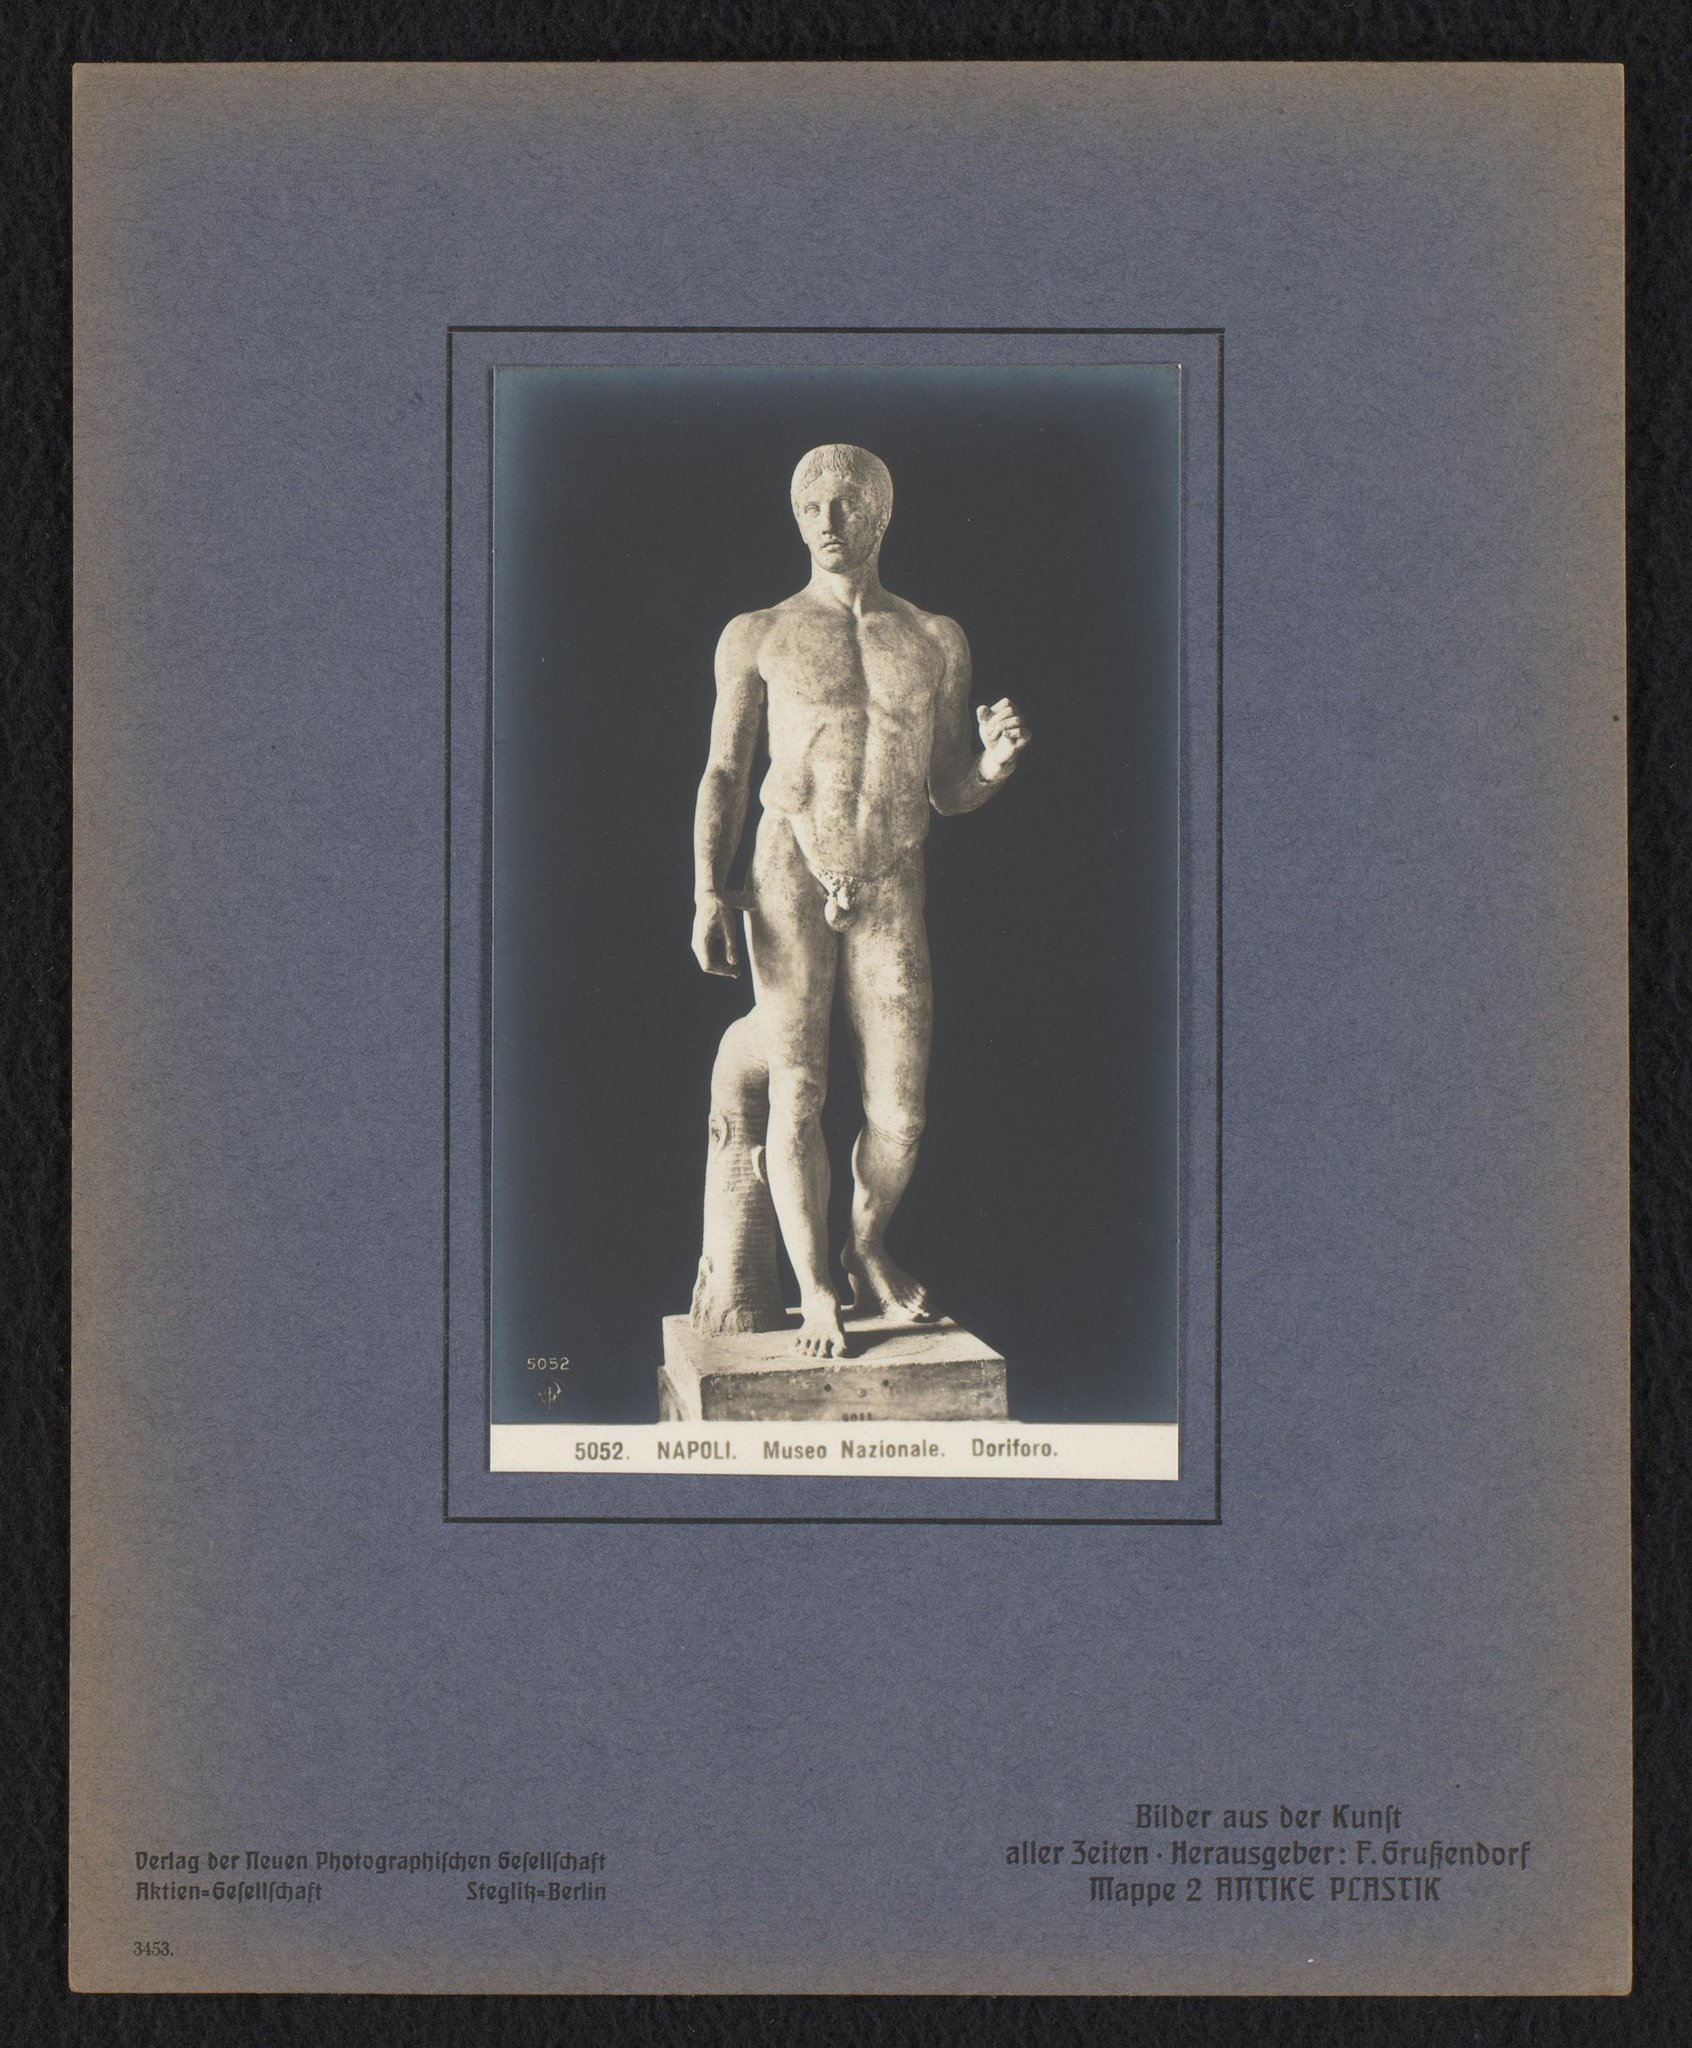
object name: photograph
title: Standbeeld van een doruphoros of speerdrager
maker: Anonymous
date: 1906-1911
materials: paper, cardboard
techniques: gelatin silver print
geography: steglitz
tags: sculpture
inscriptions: number: ‘5052.’